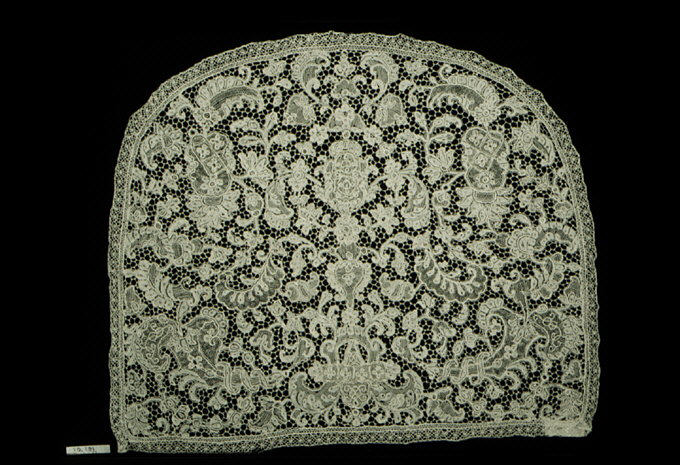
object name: cap crown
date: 1701-1733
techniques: lace